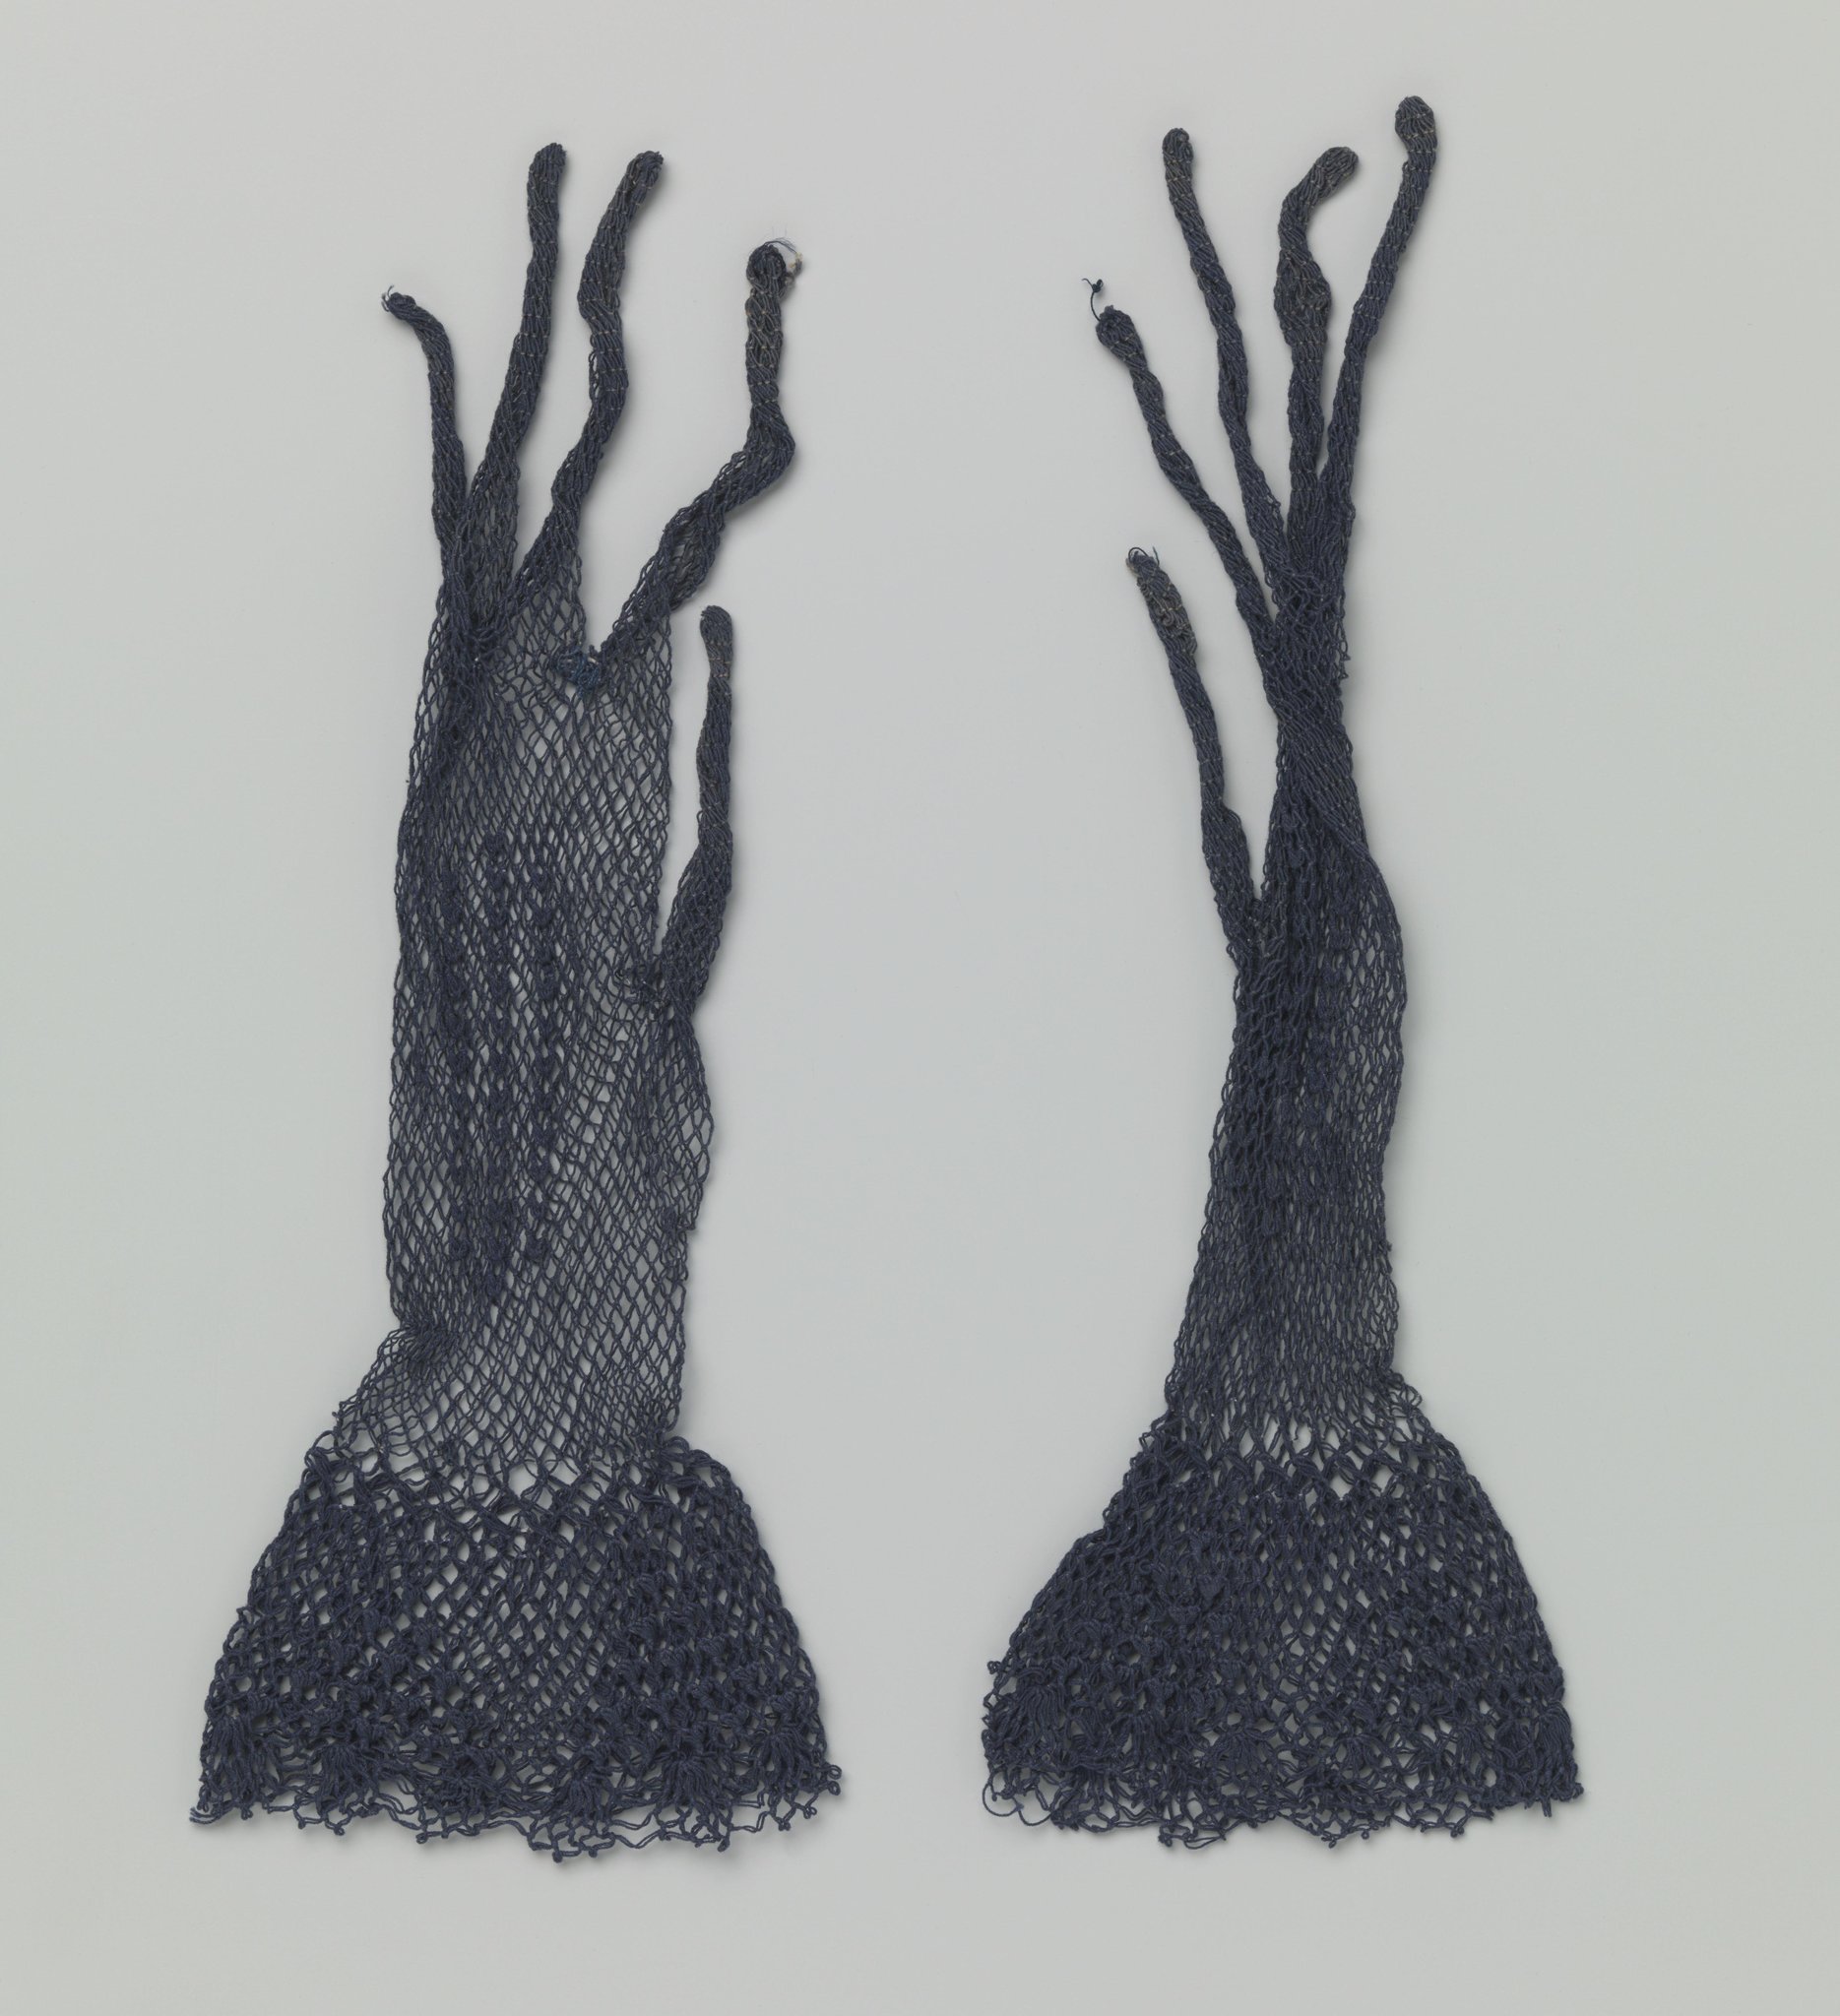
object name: glove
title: Linkerhandschoen van blauw katoen in Egyptisch vlechtwerk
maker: Anonymous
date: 1910-1925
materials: cotton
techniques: sprang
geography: netherlands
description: Linkerhandschoen van blauw katoen in Egyptisch vlechtwerk.